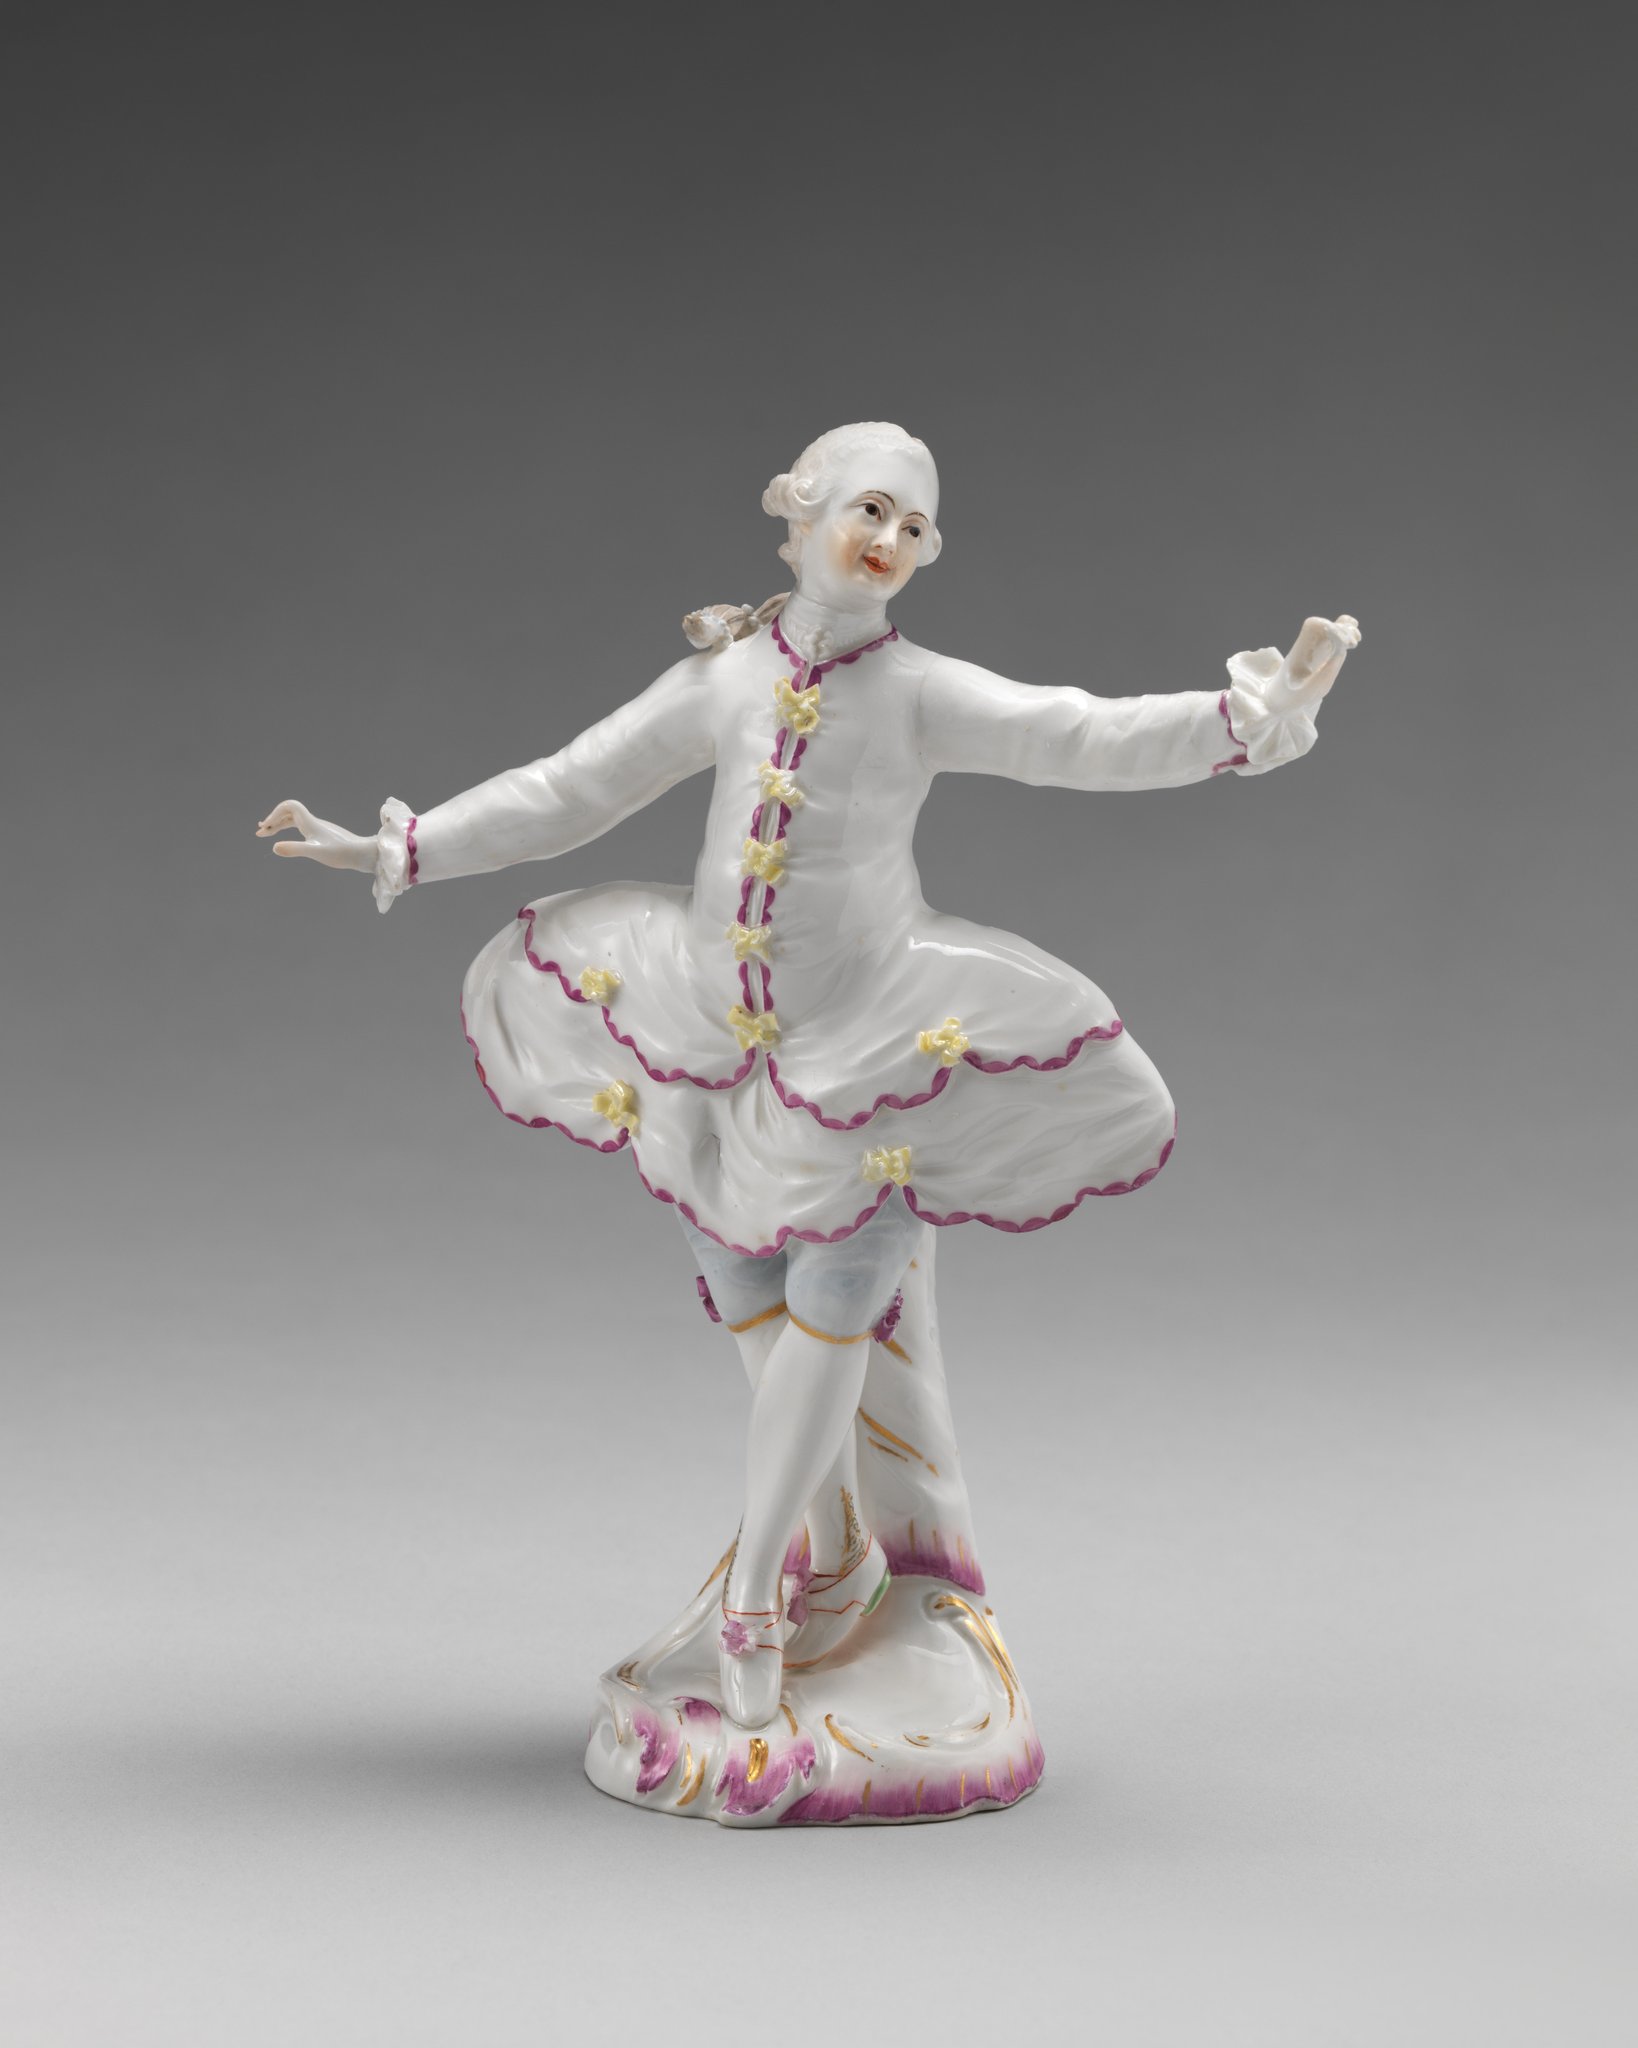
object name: figure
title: Dancer (one of a pair)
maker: höchst manufactory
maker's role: manufactory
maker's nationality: german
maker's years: 1746-1796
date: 1758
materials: hard paste porcelain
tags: men,dancers